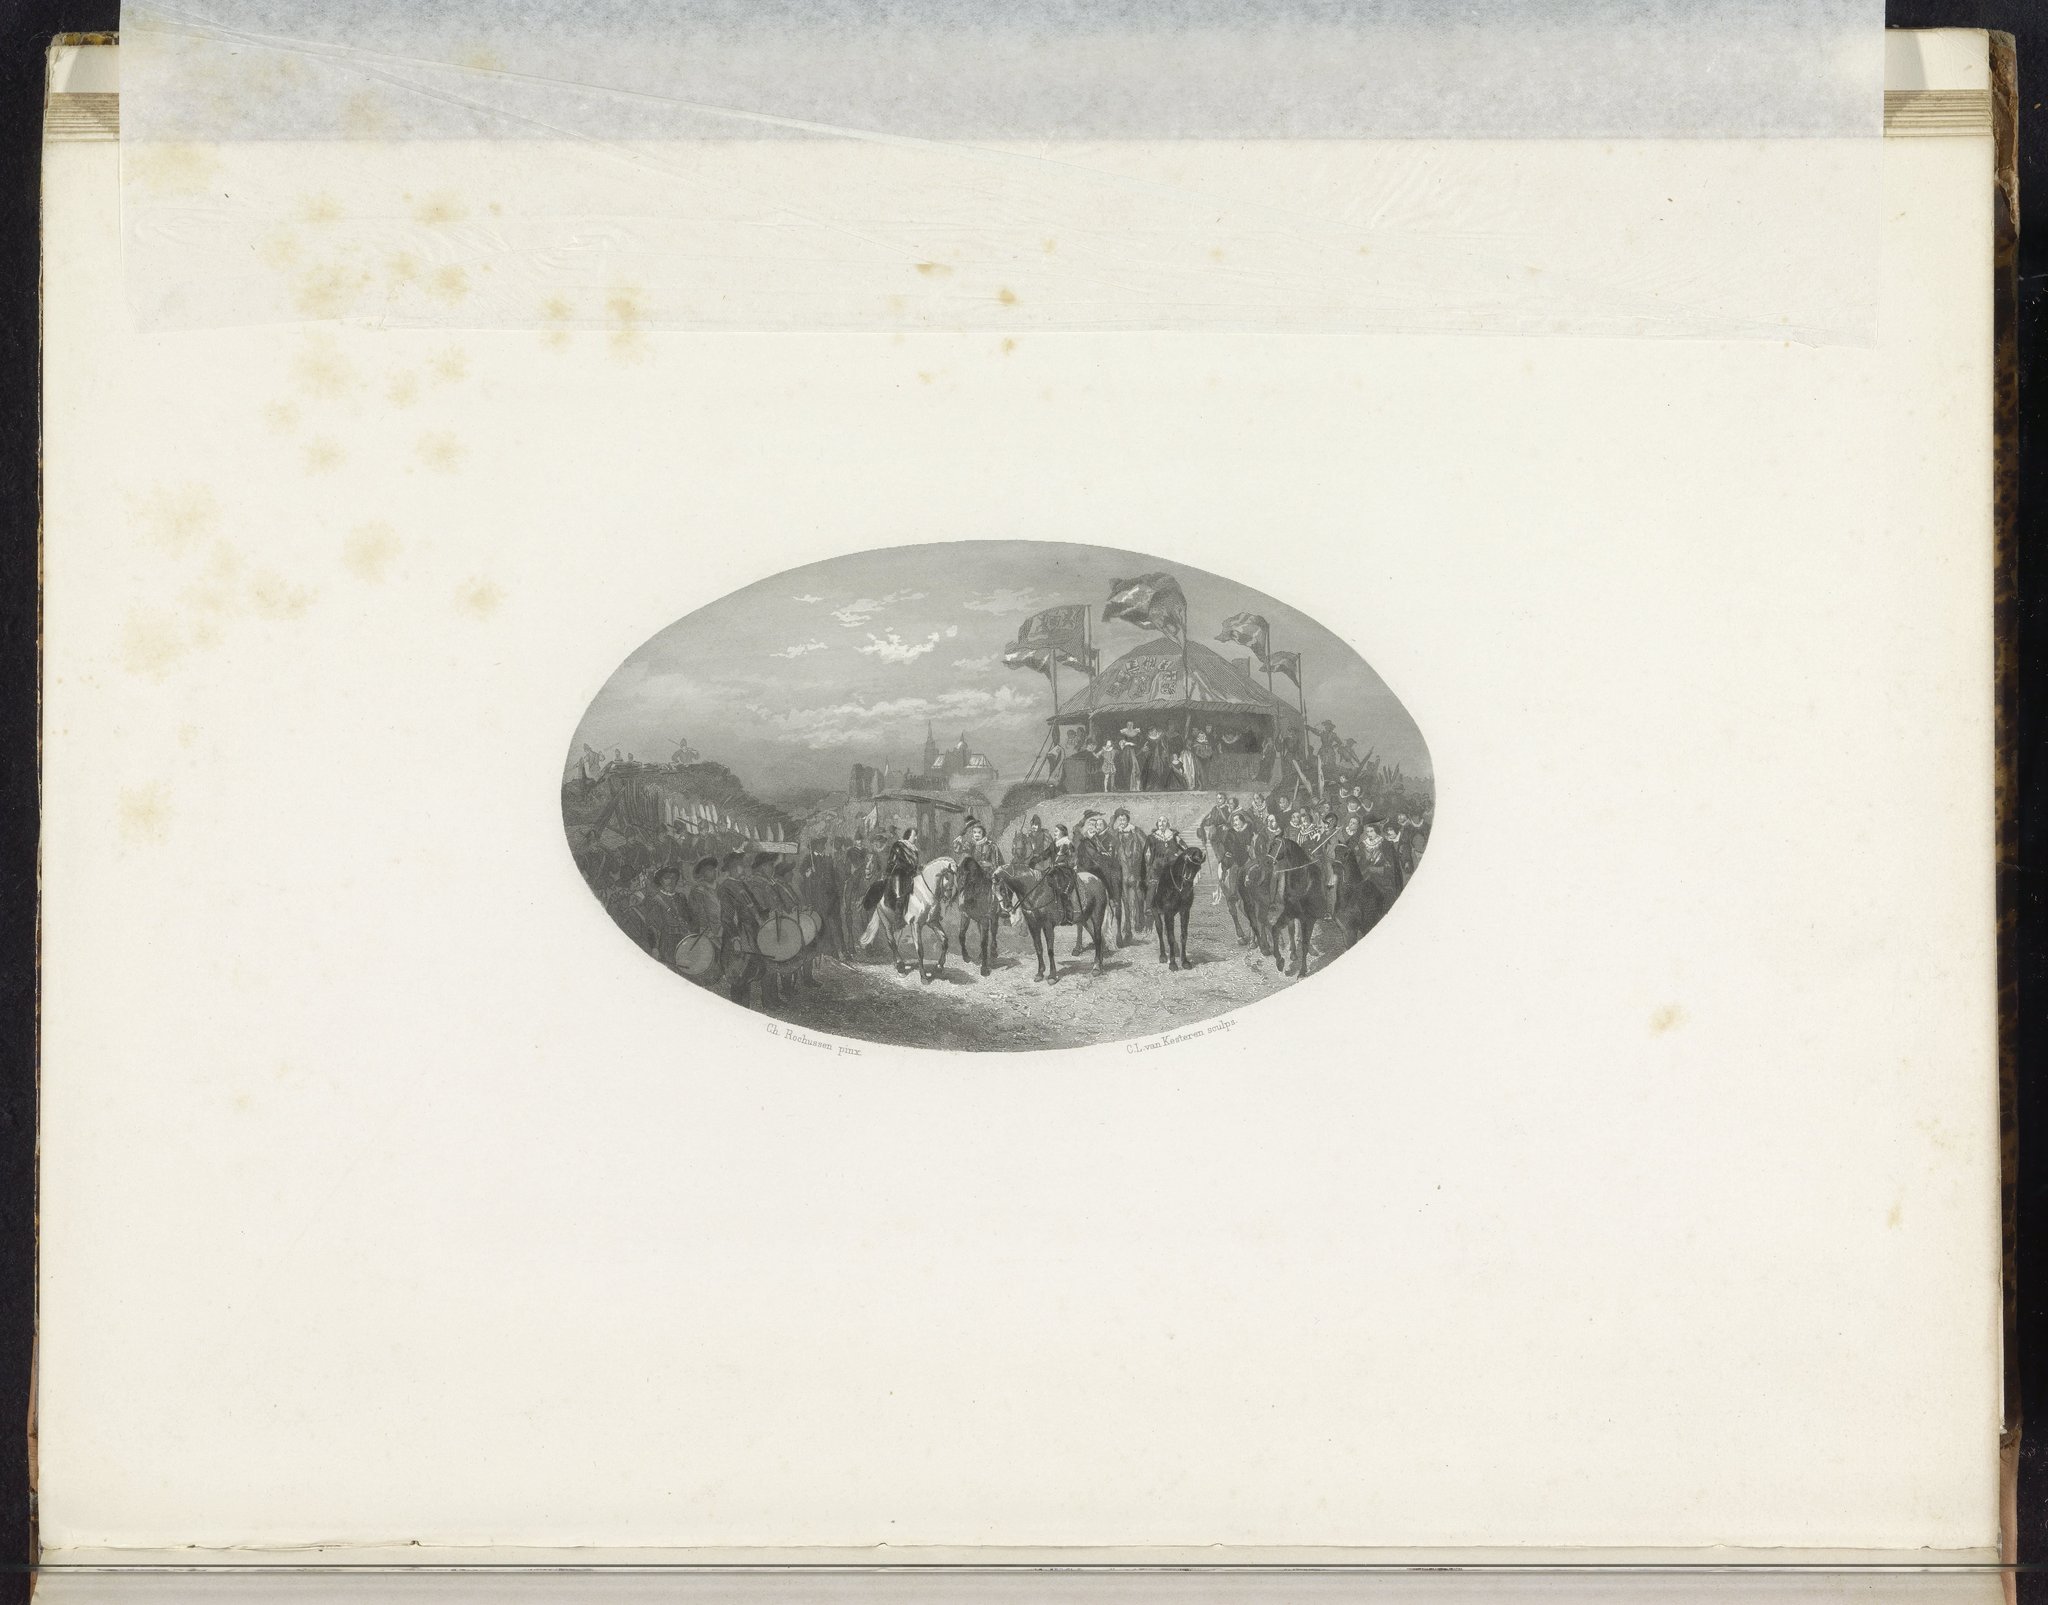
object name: history print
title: De inneming van 's Hertogenbosch door Frederik Hendrik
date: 1865-1870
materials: paper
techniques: engraving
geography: netherlands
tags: frederick henry (prince of orange), capture of city (after the siege), den bosch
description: De inname van 's-Hertogenbosch door het Staatse leger onder Frederik Hendrik, 17 september 1629. Onderdeel van de groep staalgravures naar de schilderijen van de Historische Galerij der Maatschappij Arti et Amicitiae.